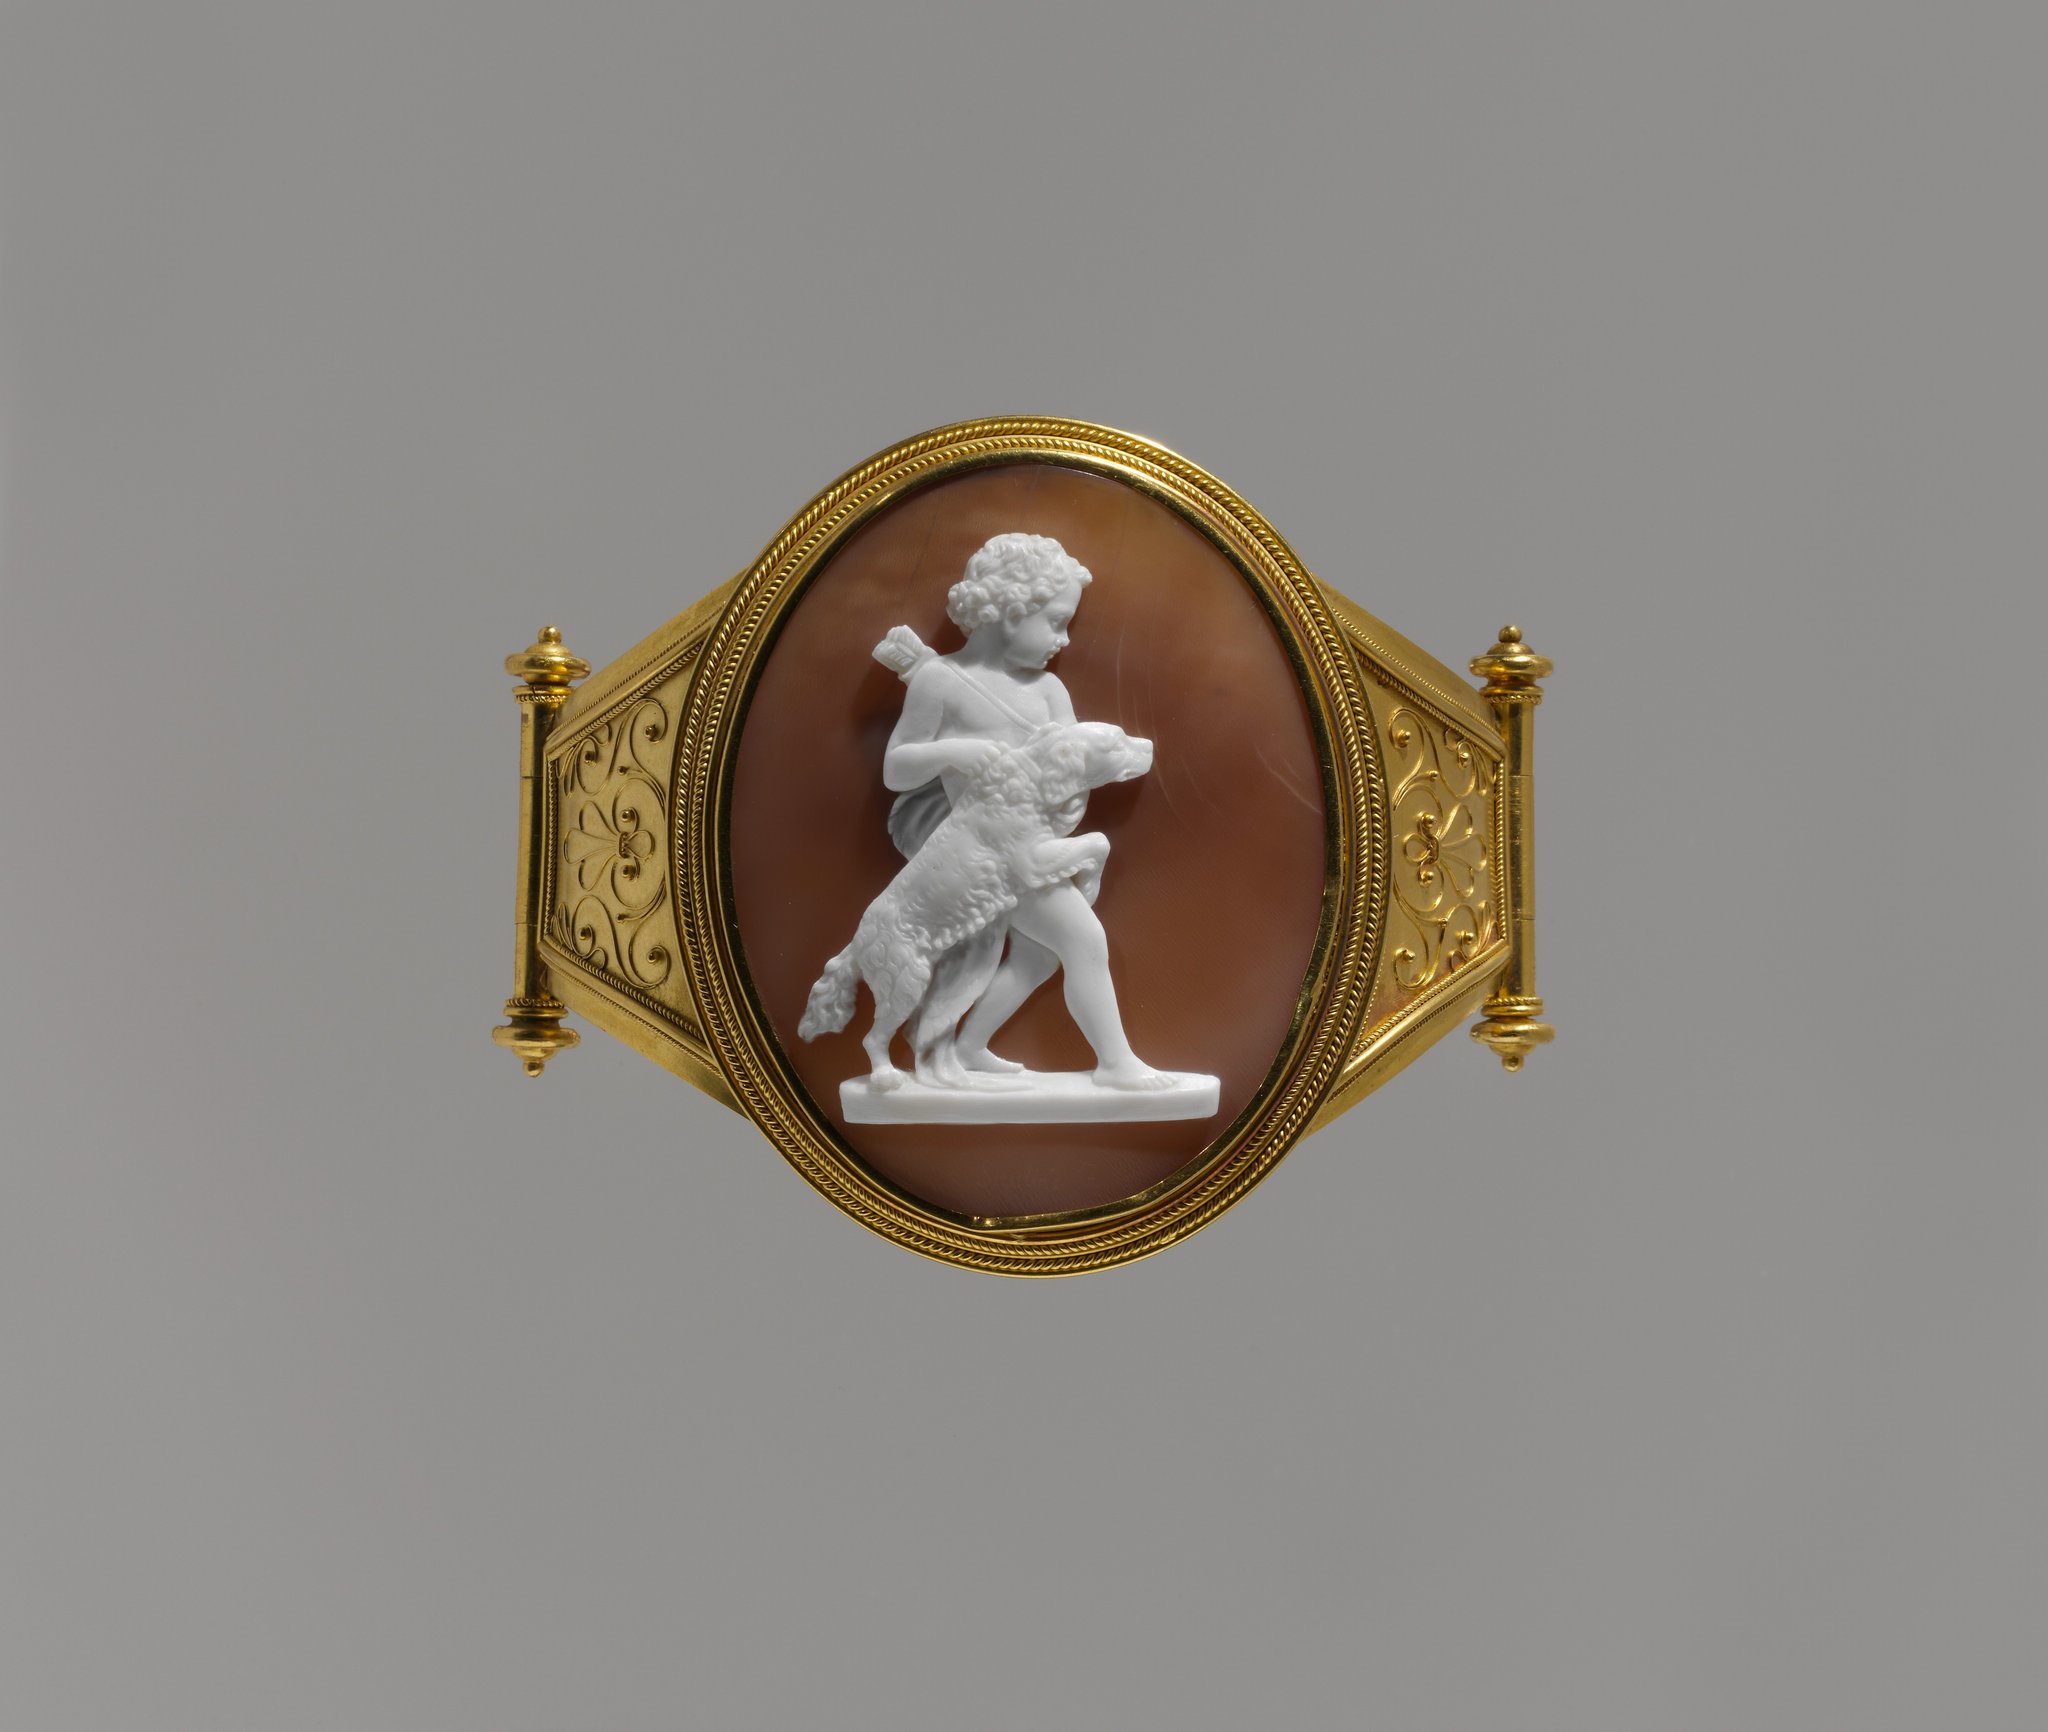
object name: bracelet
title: Cupid with a Dog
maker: luigi saulini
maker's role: maker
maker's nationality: italian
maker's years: 1819-1883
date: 1860-1870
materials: gold, shell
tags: cupid,dogs